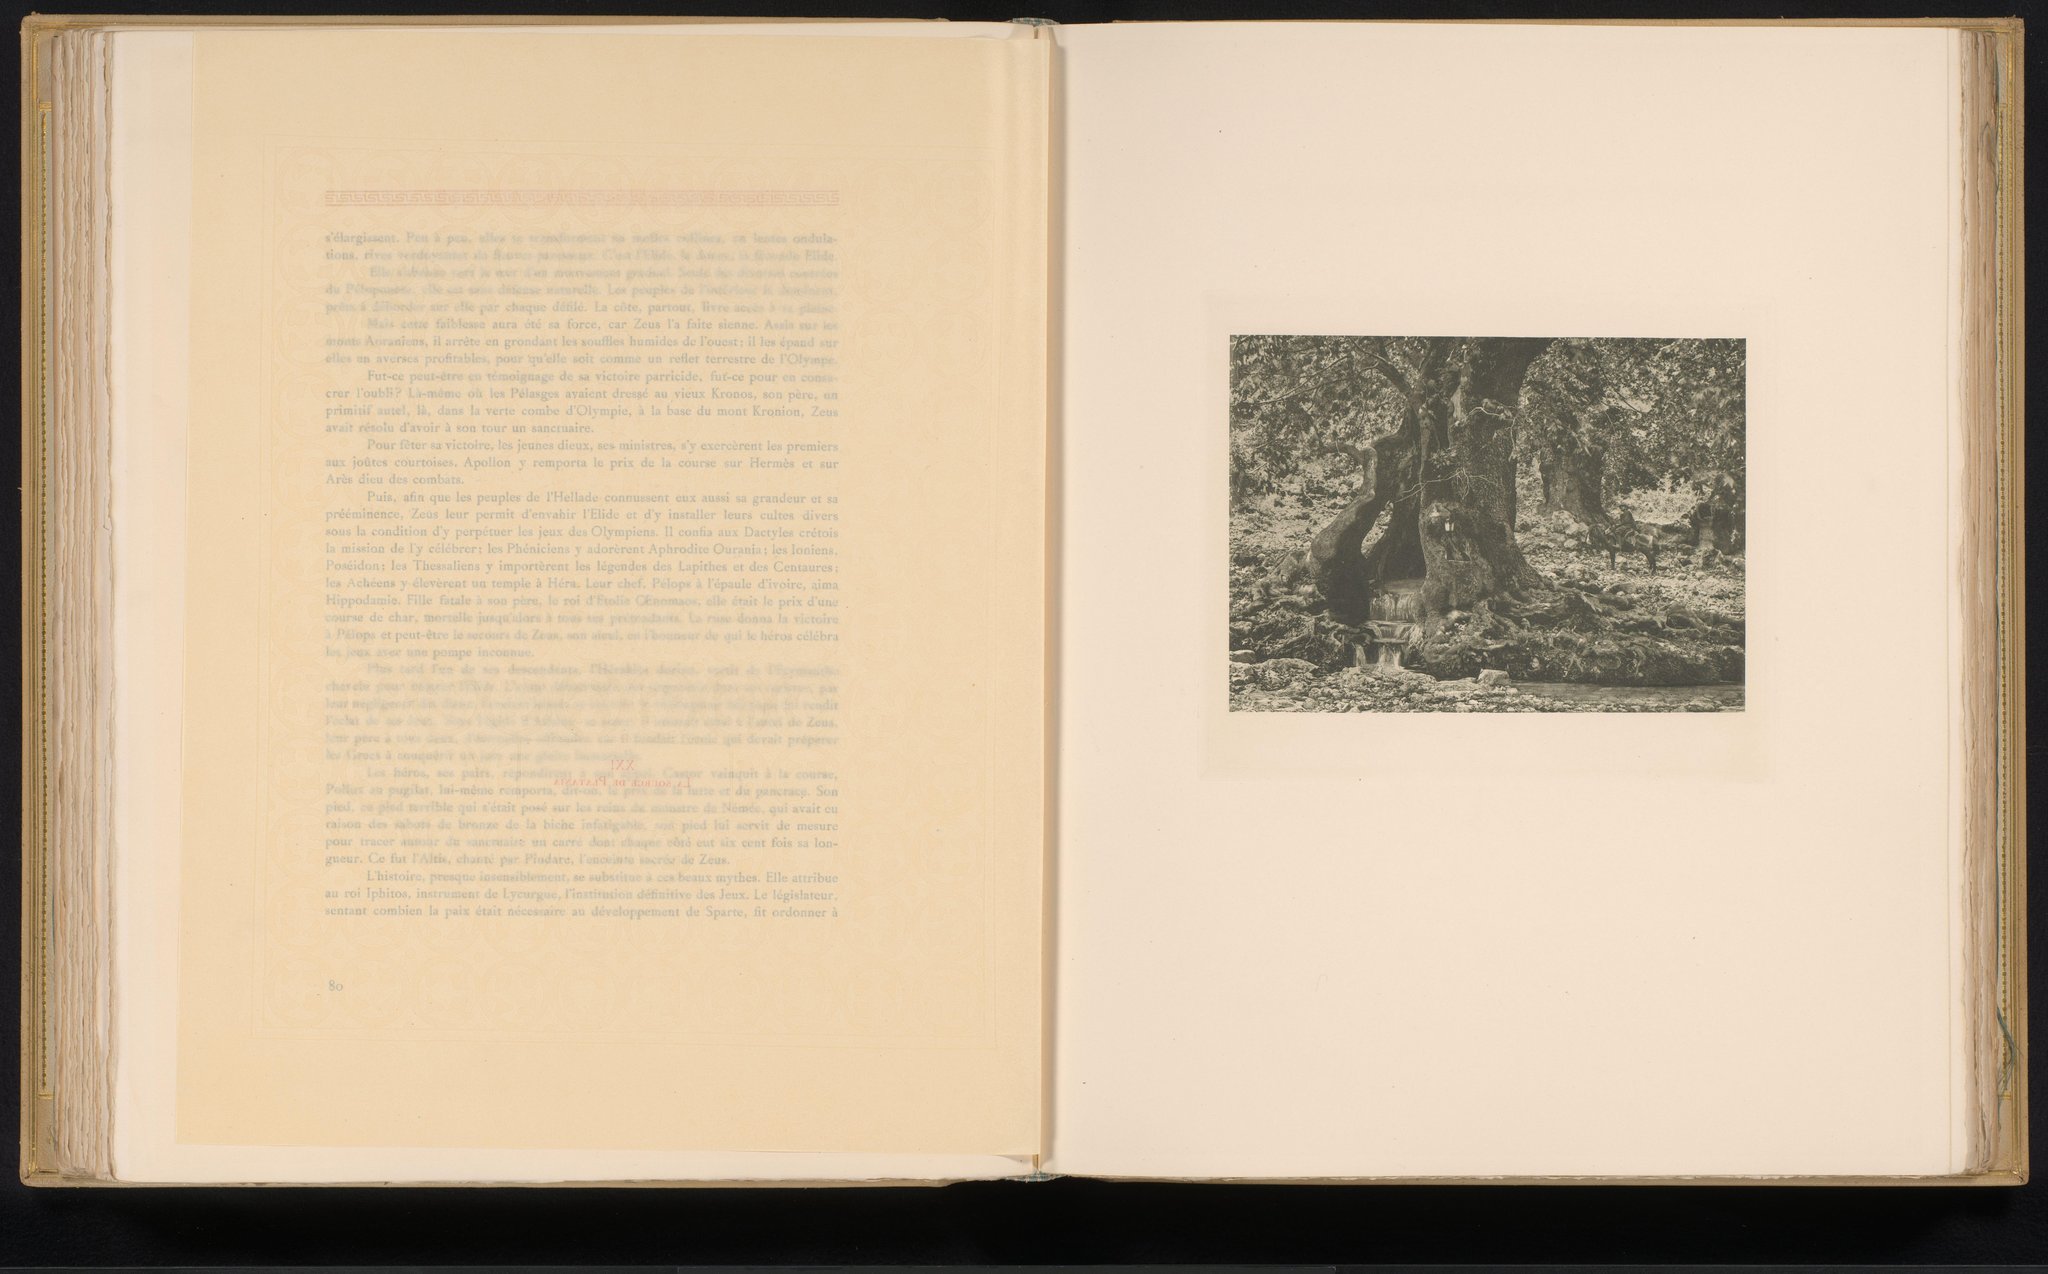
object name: page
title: La source de Platania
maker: frédéric boissonnas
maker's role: fotograaf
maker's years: 1858-1946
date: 1905-1910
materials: paper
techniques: photoaquatint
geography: berlin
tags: trees: plane-tree, brook